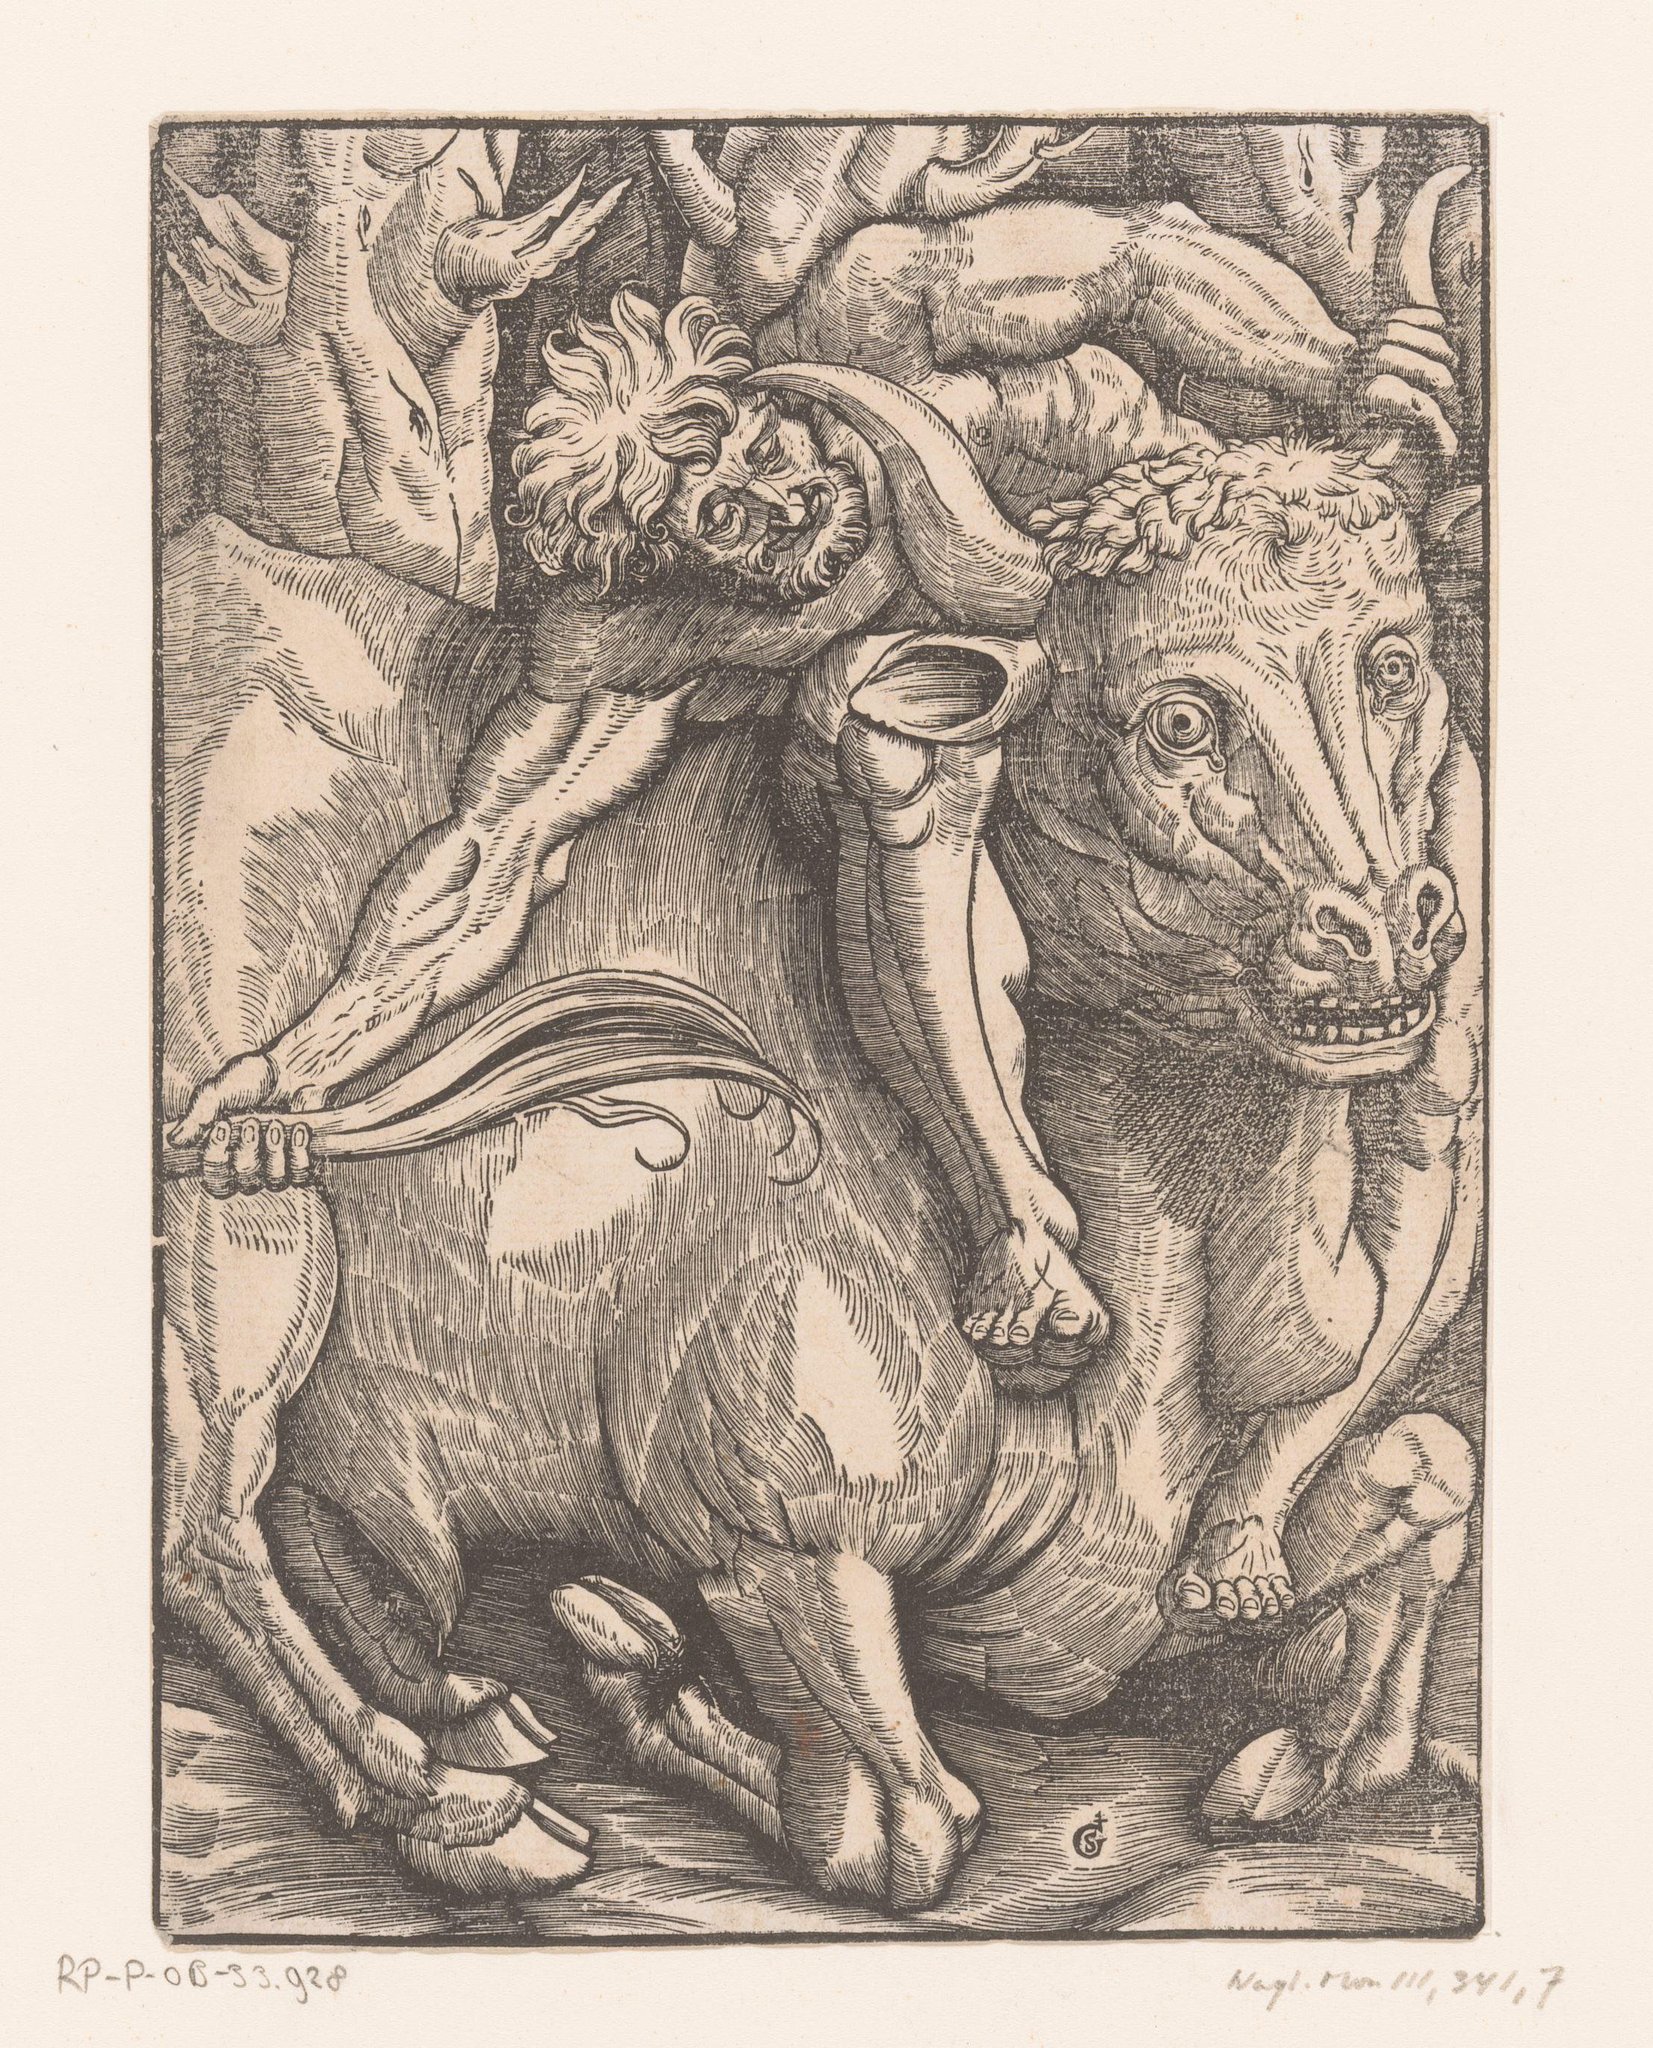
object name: print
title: Werken van Hercules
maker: gabriel salmon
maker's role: print maker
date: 1528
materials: paper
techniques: woodcut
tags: while fighting with hercules the river-god achelous changes himself into a bull, or a bull-headed man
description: Prent maakt deel uit van een ongenummerde serie van twaalf prenten.